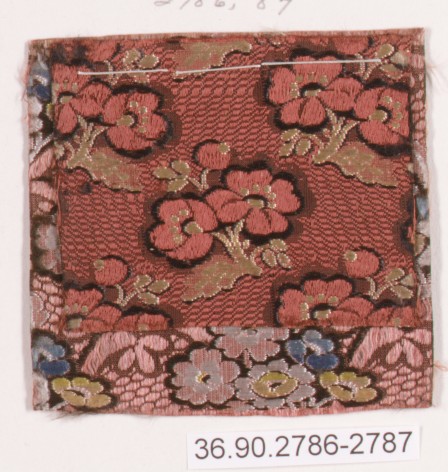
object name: piece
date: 1801-1900